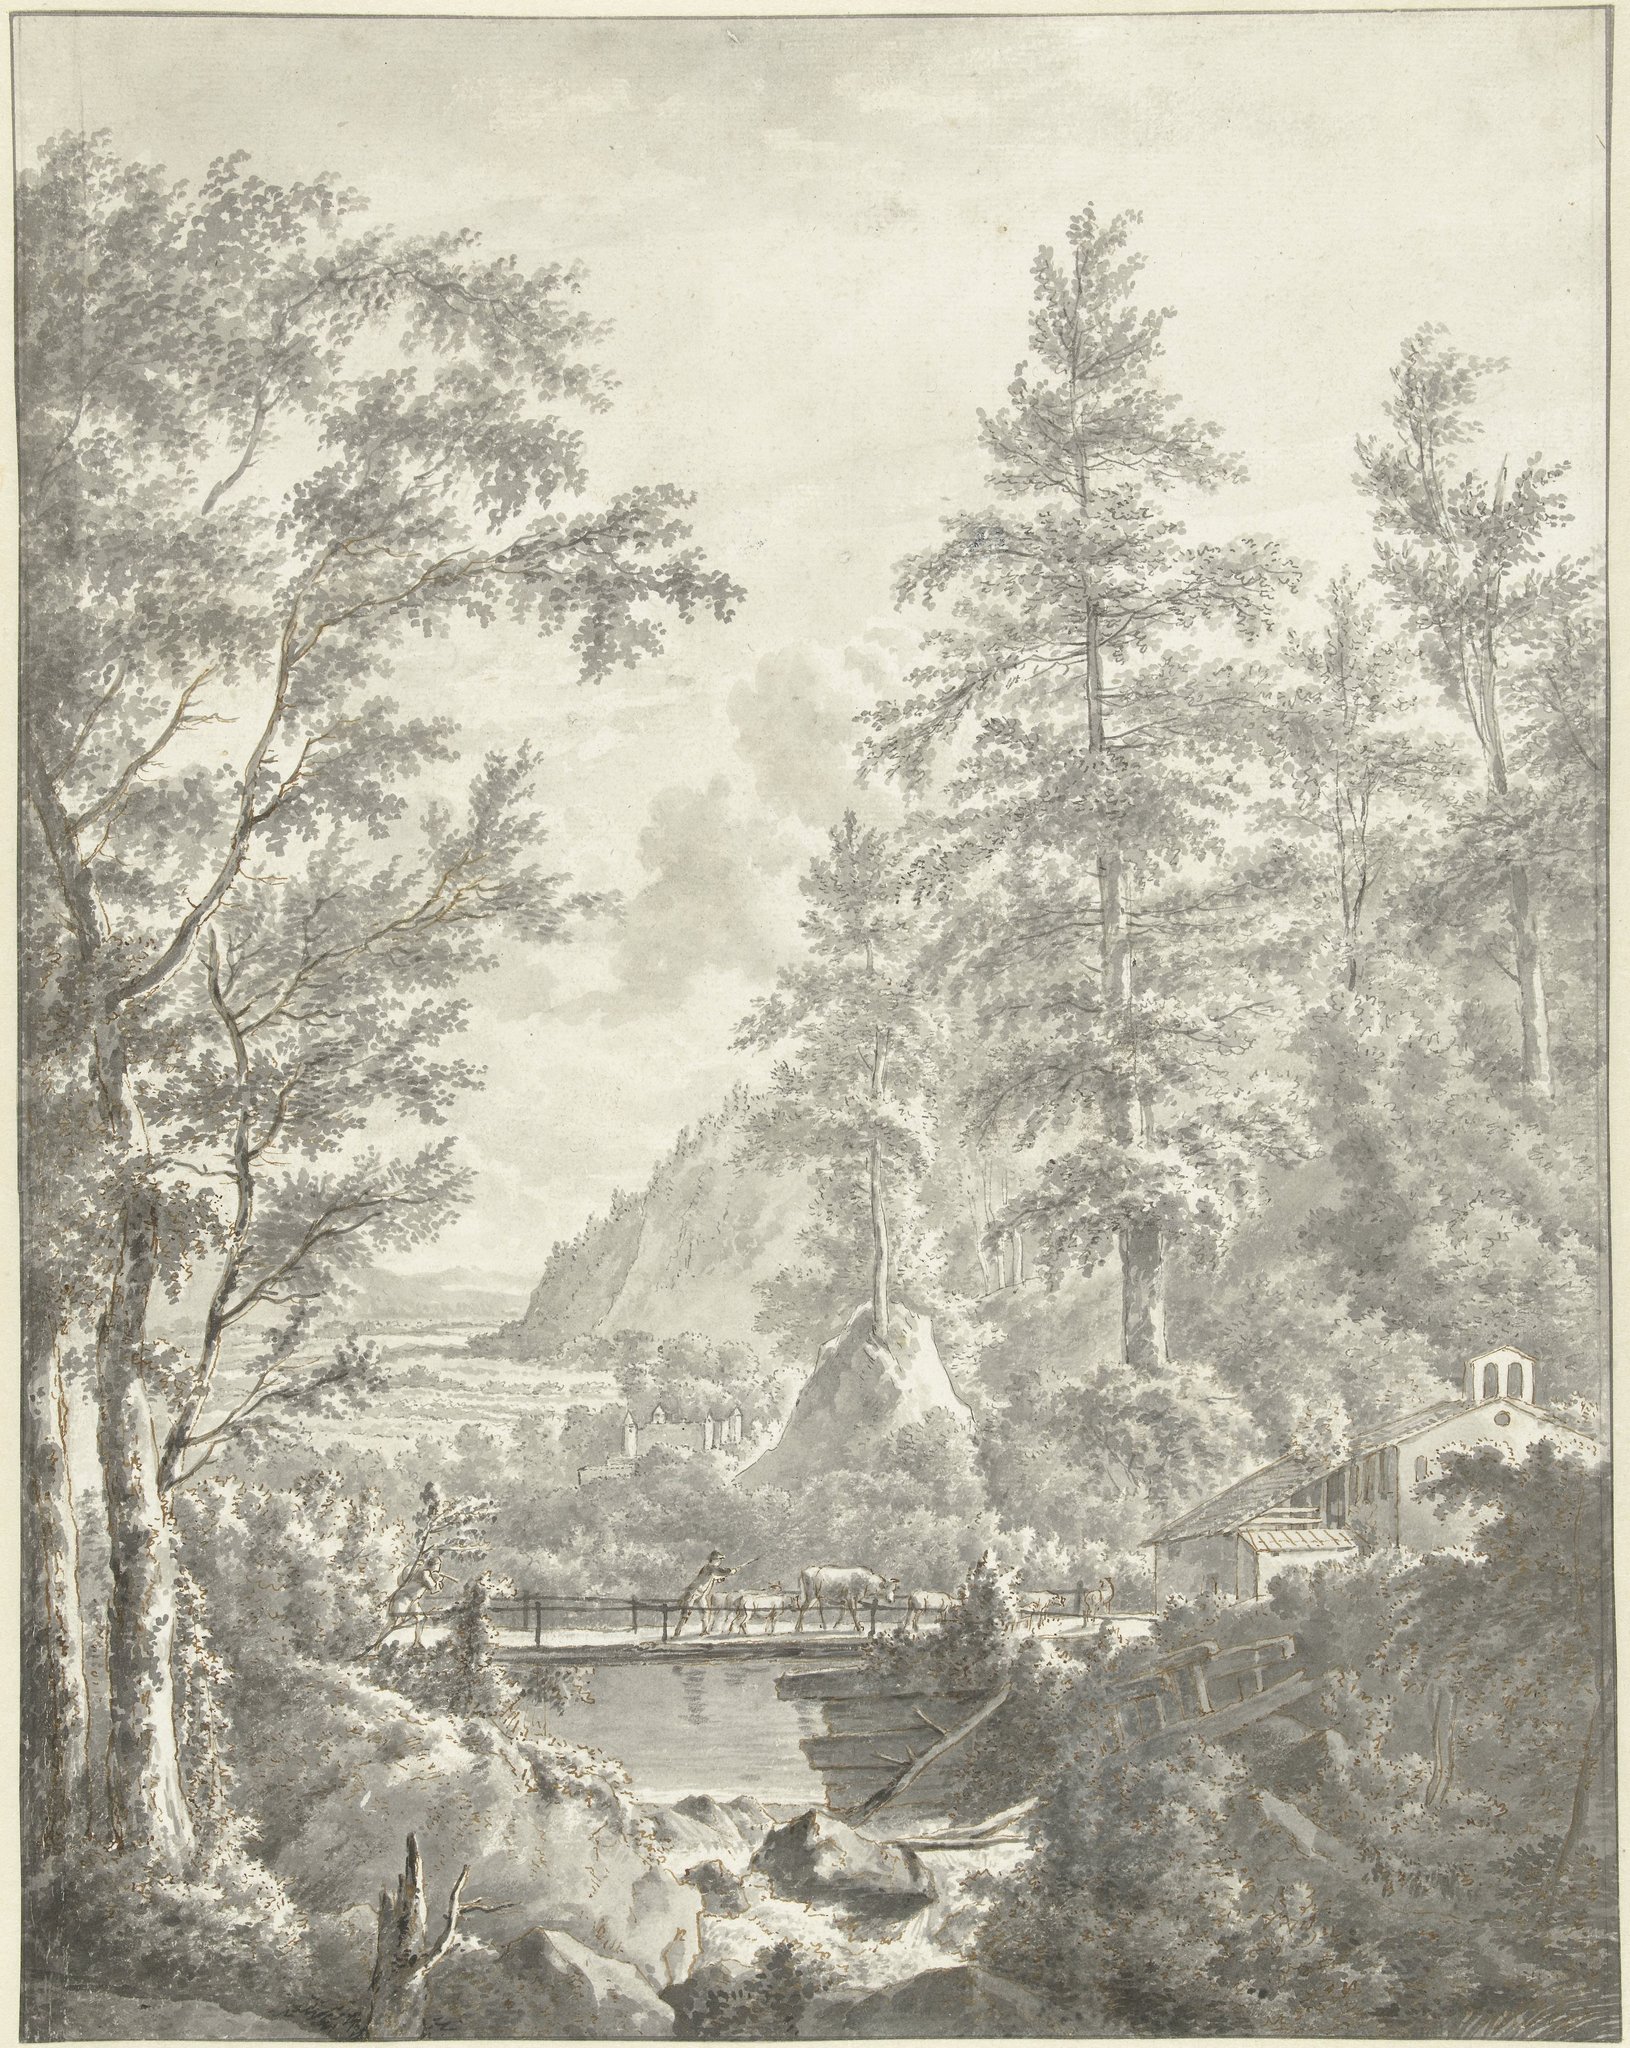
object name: drawing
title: Bergachtig landschap in Spanje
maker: cornelis apostool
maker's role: draughtsman, print maker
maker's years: 1762-1844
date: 1772-1844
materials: ink, paper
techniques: brush, pen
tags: mountains, spain